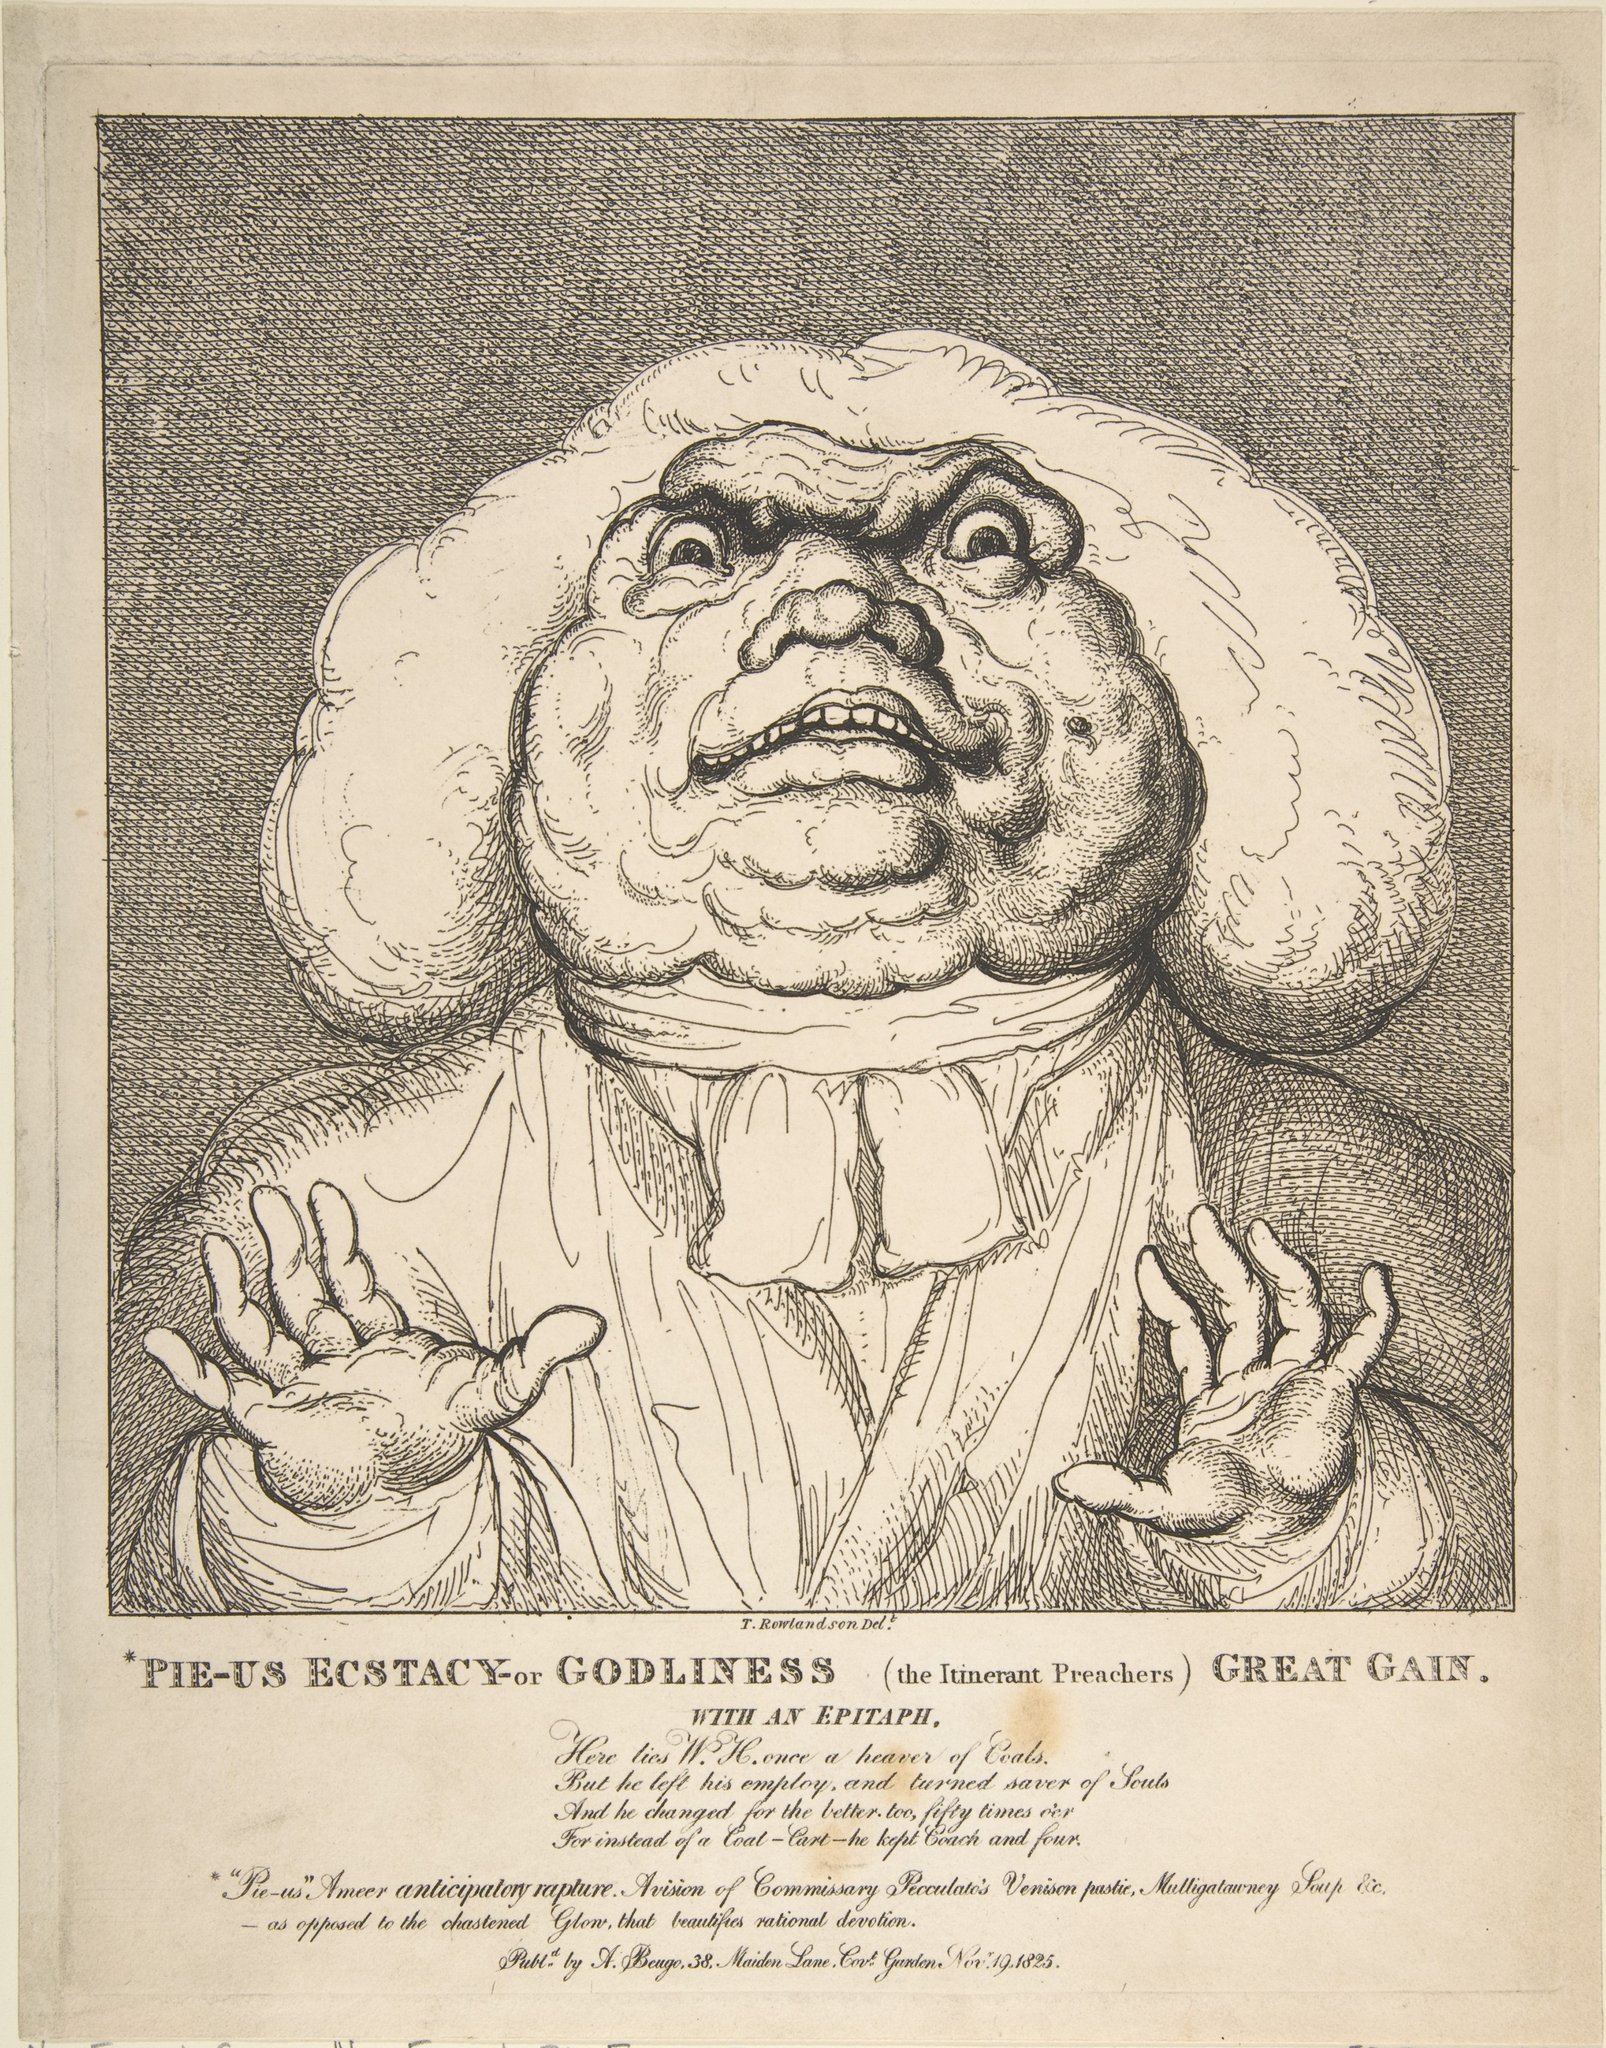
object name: print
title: Pie-Us Ecstacy – or Godliness (the Itinerant Preachers) Great Gain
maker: thomas rowlandson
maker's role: artist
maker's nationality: british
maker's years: 1757-1827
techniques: etching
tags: men,caricature